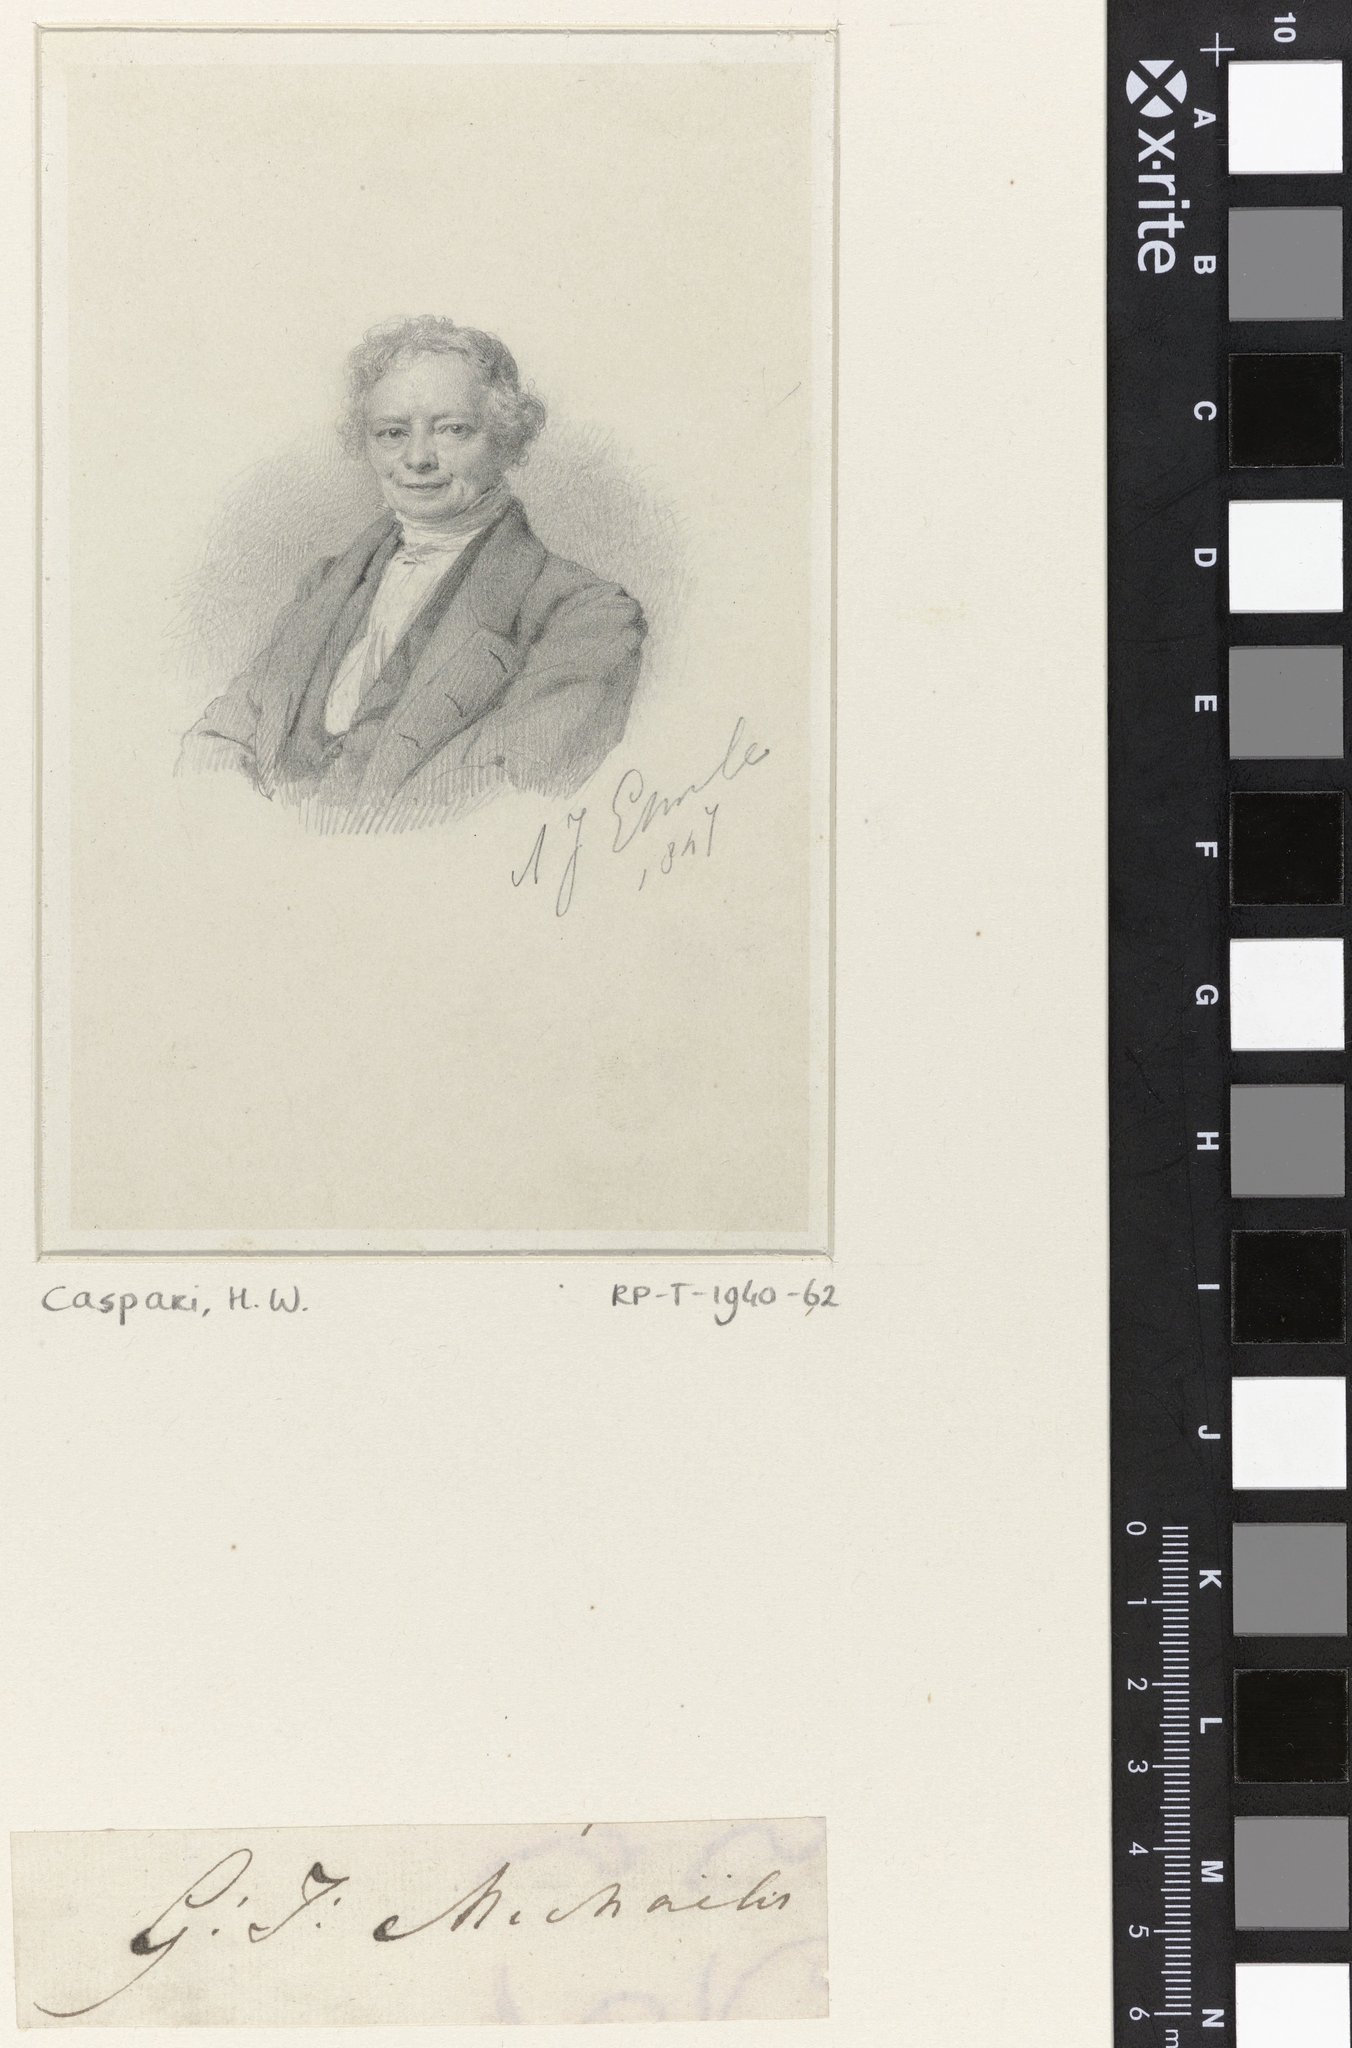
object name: drawing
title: Portret van Gerrit Jan Michaëlis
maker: adrianus johannes ehnle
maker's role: draughtsman, print maker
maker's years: 1819-1863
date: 1847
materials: paper, pencil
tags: amsterdam, painter, gerrit jan michaëlis, historical persons, portrait, self-portrait of artist